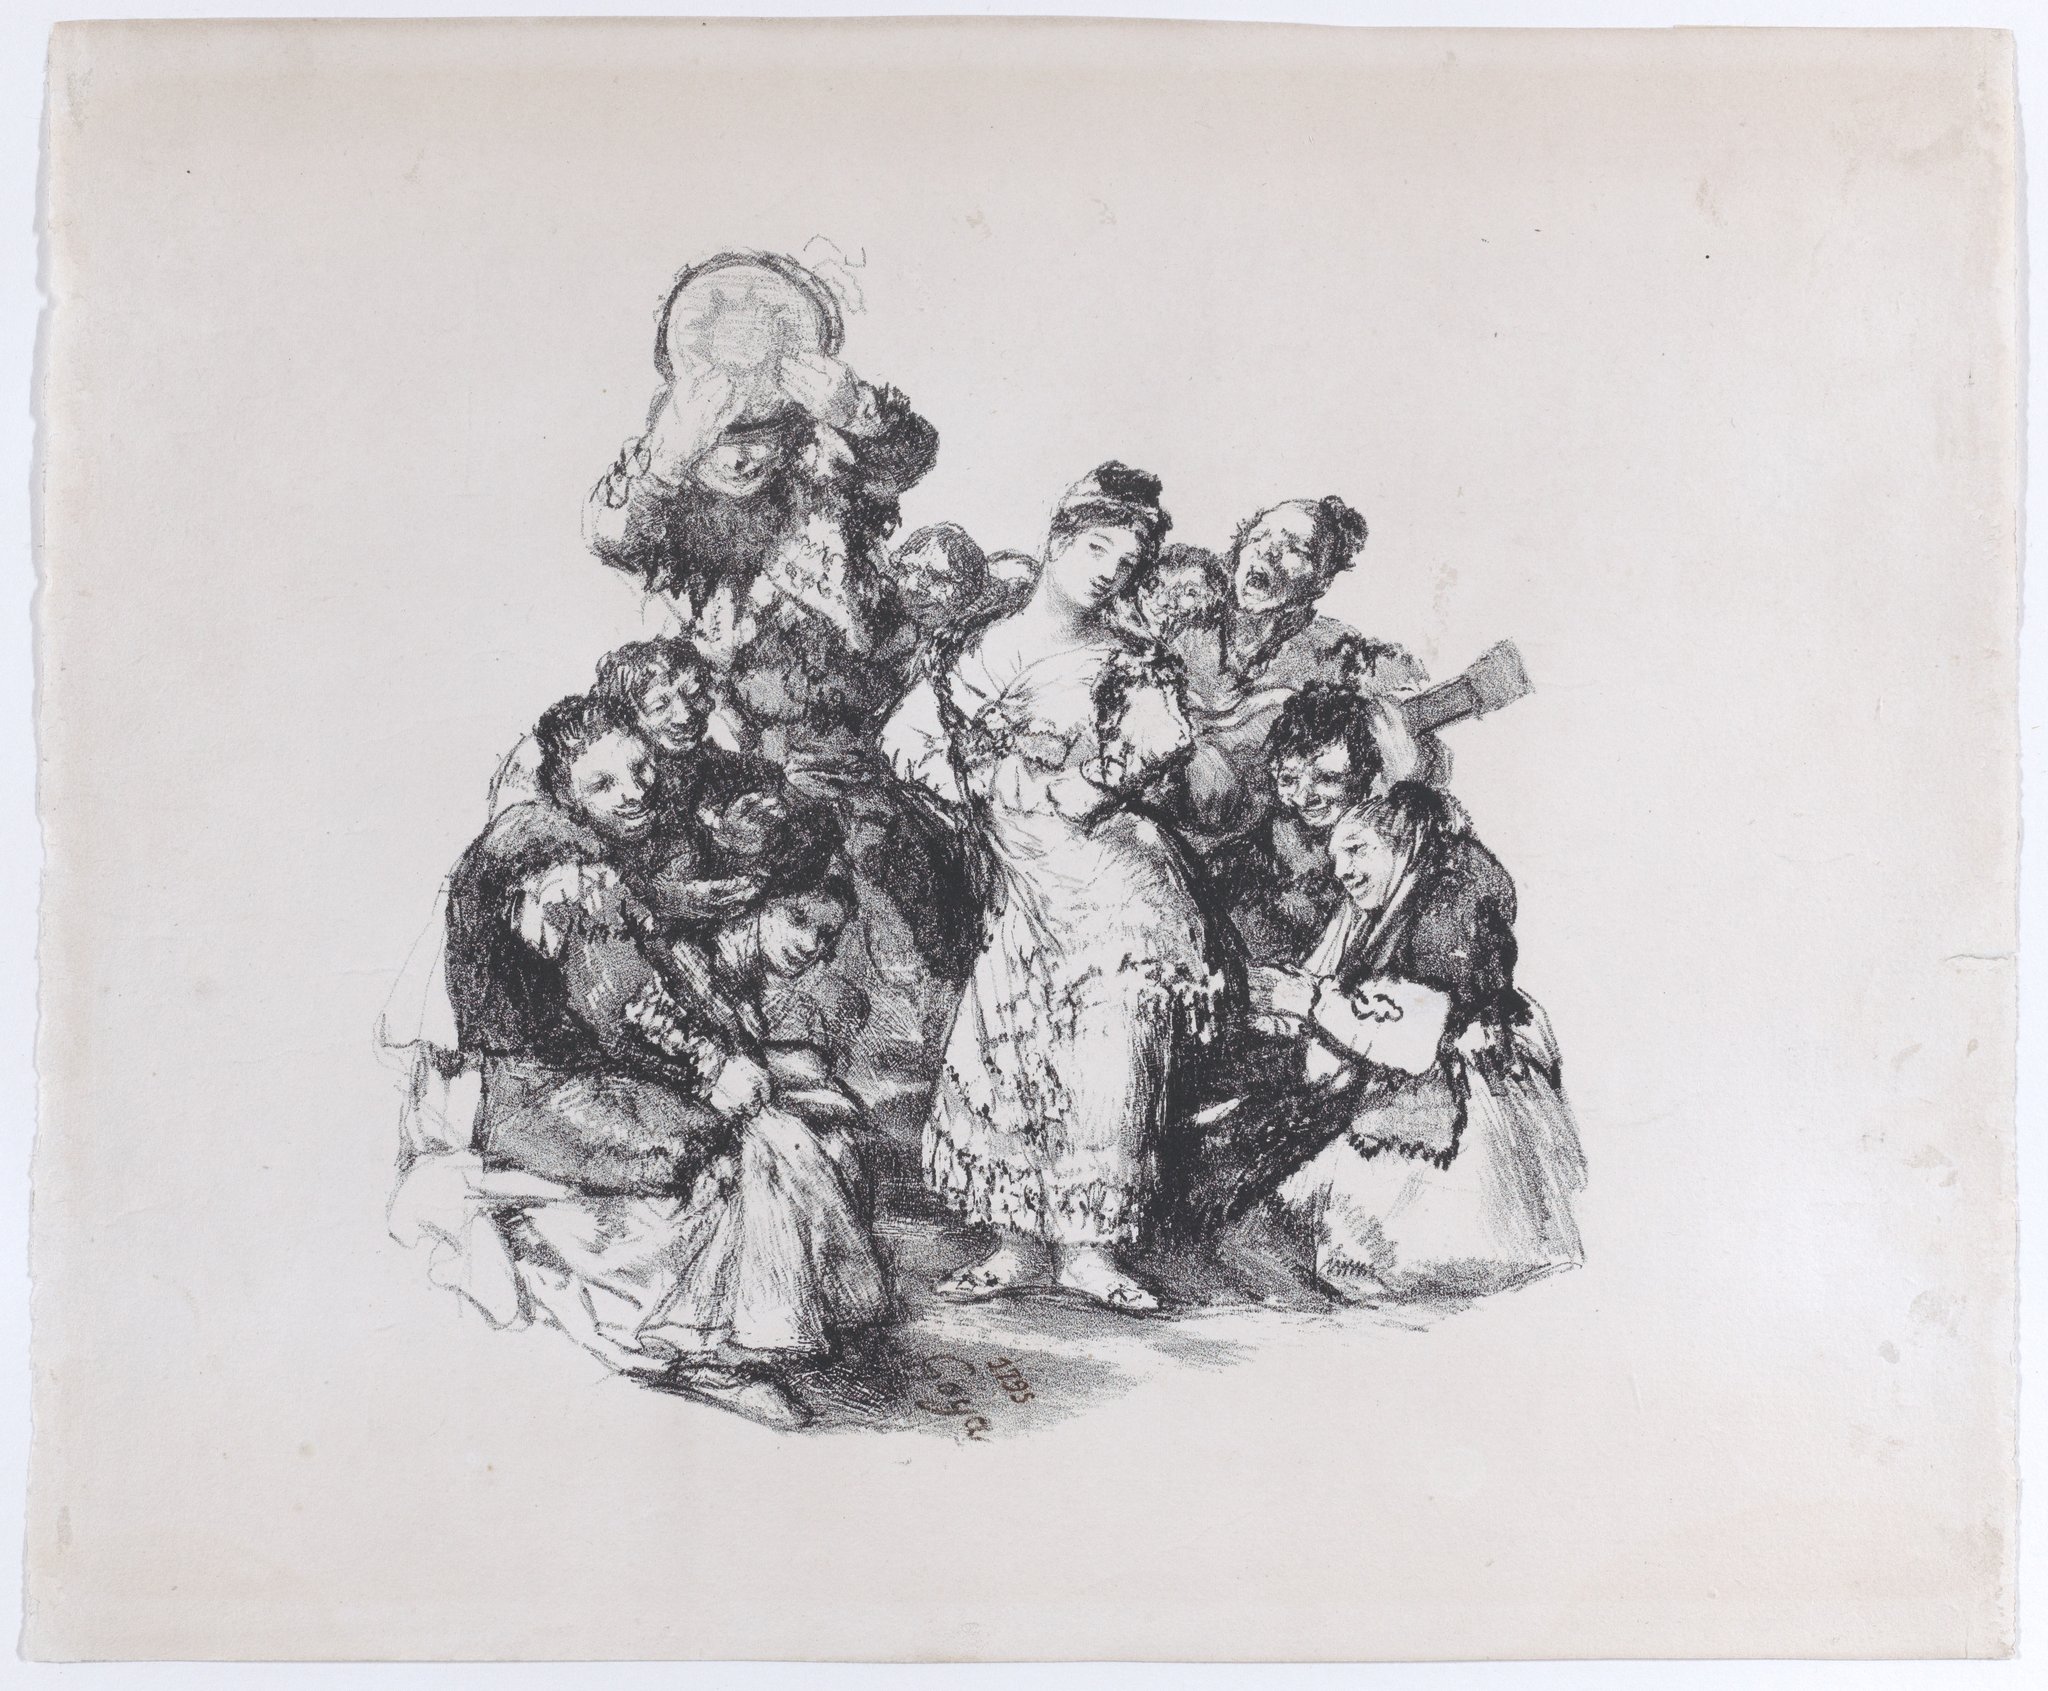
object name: print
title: The Andalusian dance (El Vito)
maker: goya (francisco de goya y lucientes)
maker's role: artist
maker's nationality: spanish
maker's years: 1746-1828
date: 1824-1825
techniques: lithograph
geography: spain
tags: women,dancing